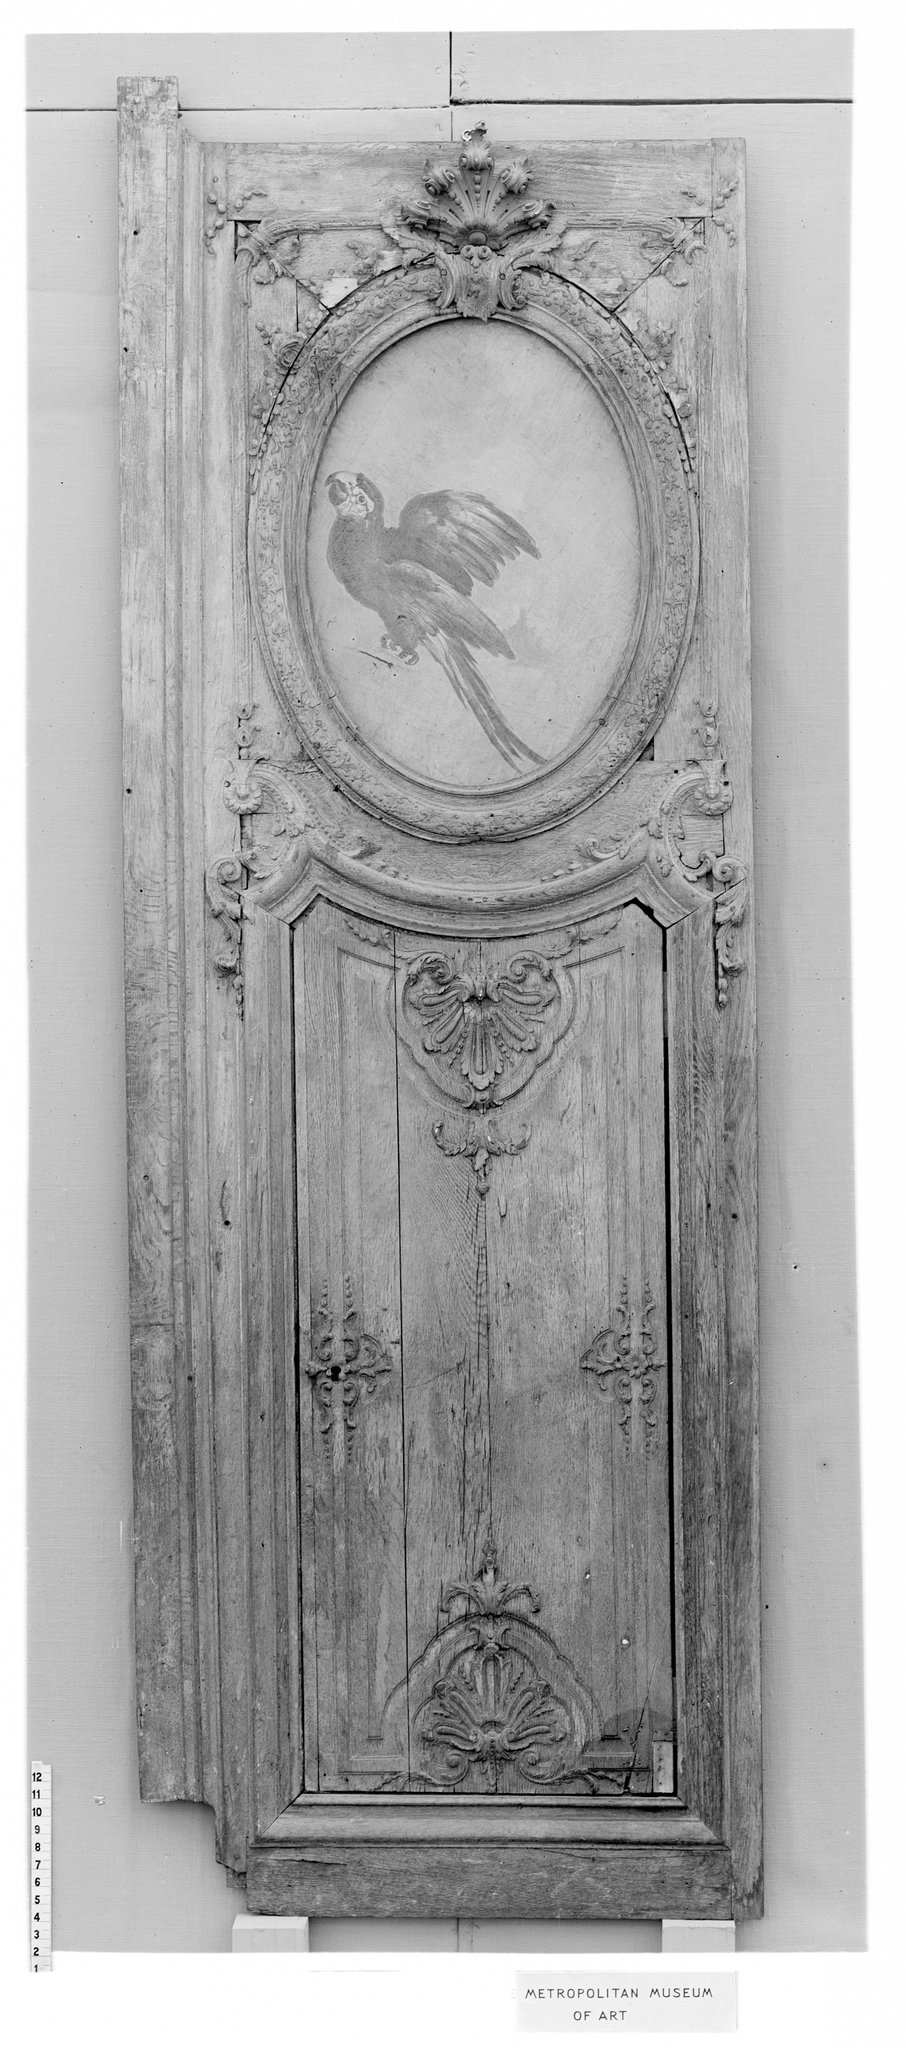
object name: wall panel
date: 1701-1725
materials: wood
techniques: carving, painting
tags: parrots